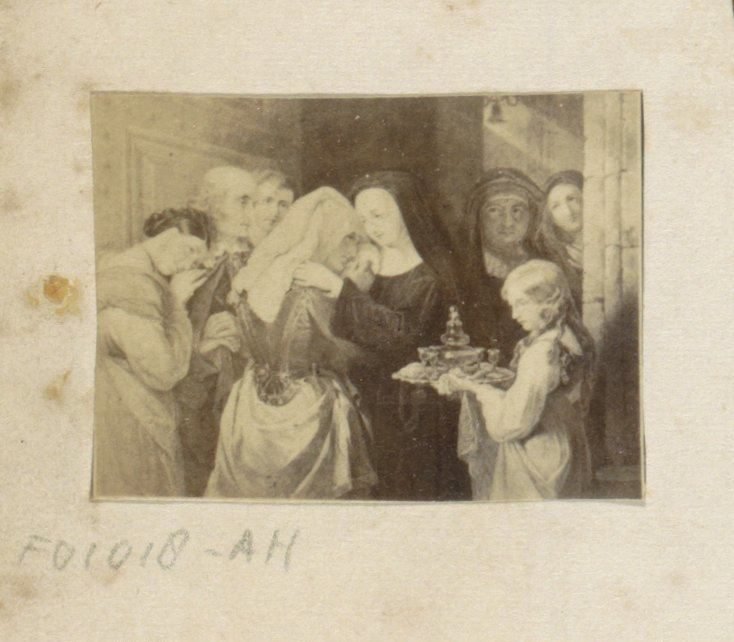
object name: reproduction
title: Fotoreproductie van (vermoedelijk) een schilderij met een drinkend gezelschap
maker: Anonymous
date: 1860-1870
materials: paper, photographic support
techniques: albumen print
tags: drinking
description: Onderdeel van Engels familiealbum met foto's van personen, reizen, cricket en kunstwerken.